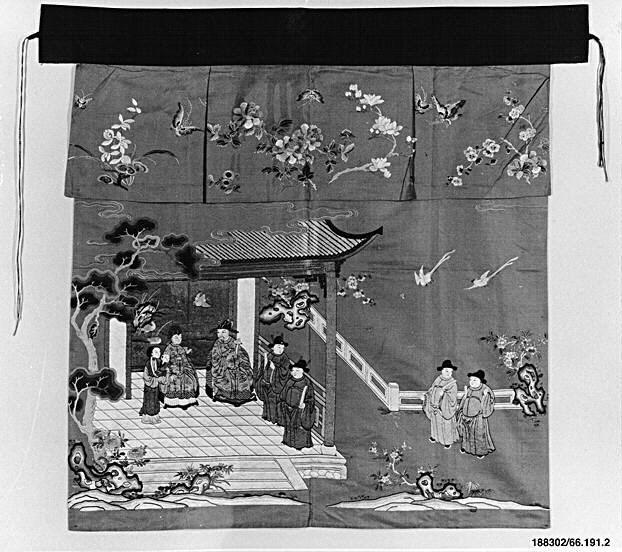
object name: valance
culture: chinese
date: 1736-1795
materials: cotton, metal thread, silk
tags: human figures,birds,flowers,trees